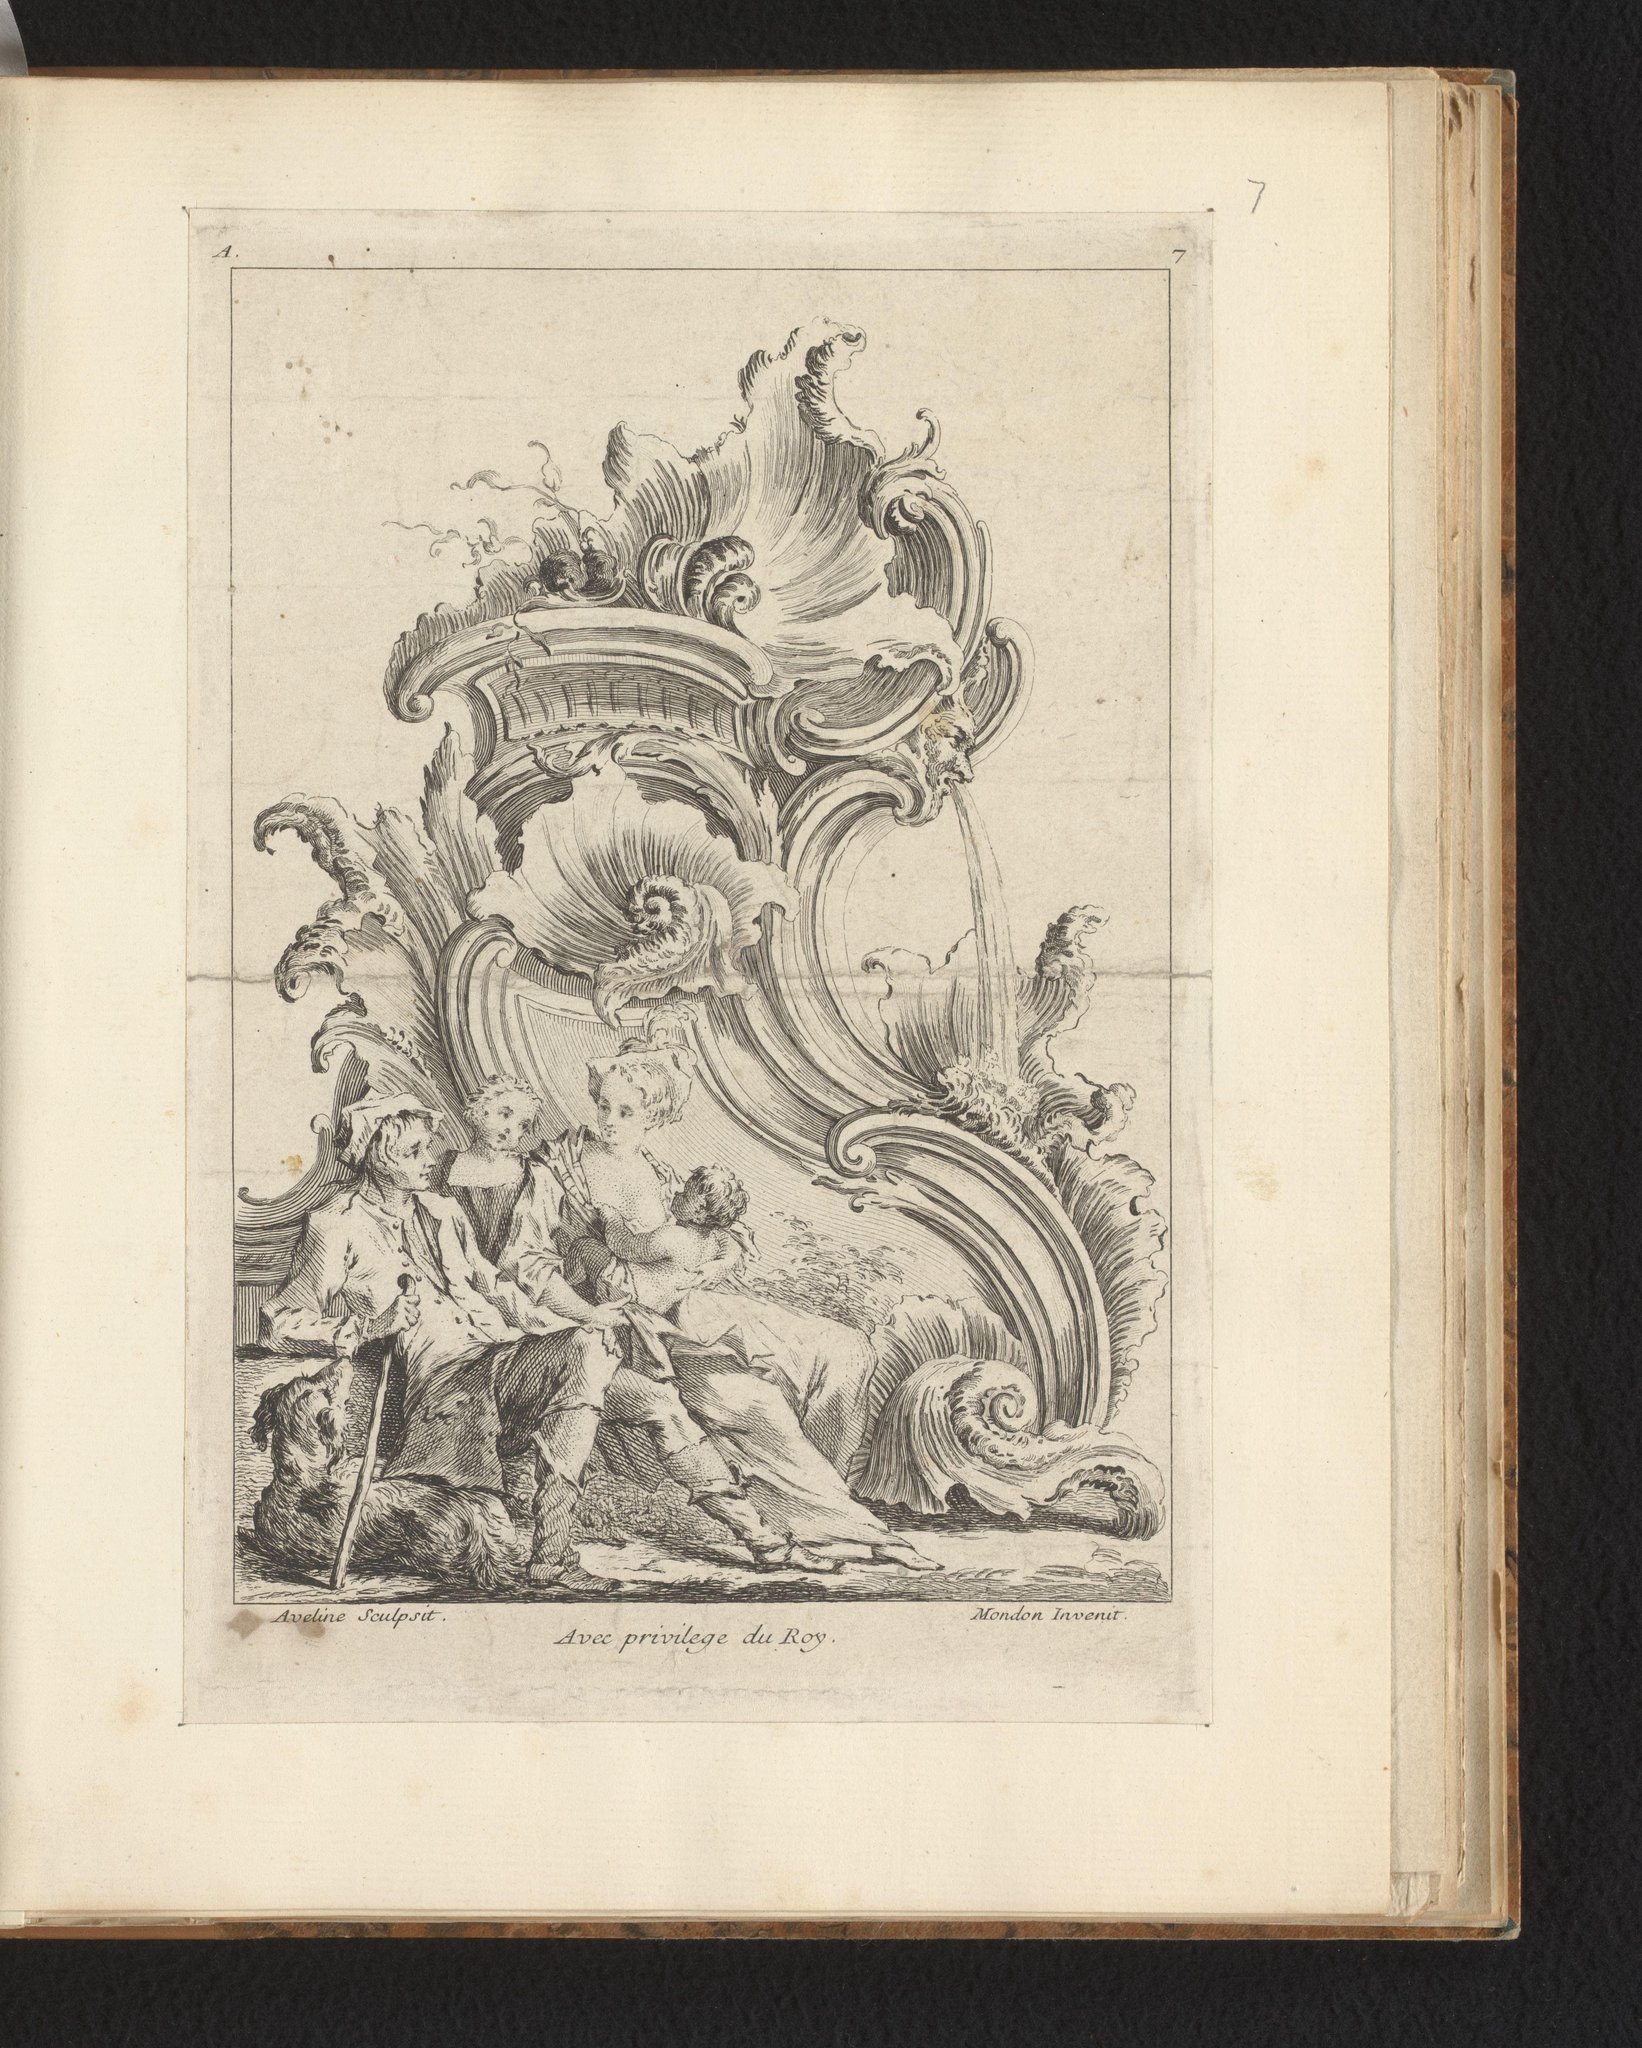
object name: print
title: Eerste serie rocailles en kartelornamenten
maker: antoine aveline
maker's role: print maker, publisher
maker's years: 1691-1743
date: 1736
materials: paper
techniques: etching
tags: rocaille ornament, herding, herdsman, herdswoman, shepherd, shepherdess, cowherd, etc., pastorals, arcadian scenes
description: Deze serie is linksboven genummerd met een letter A. Prent maakt deel uit van een album.